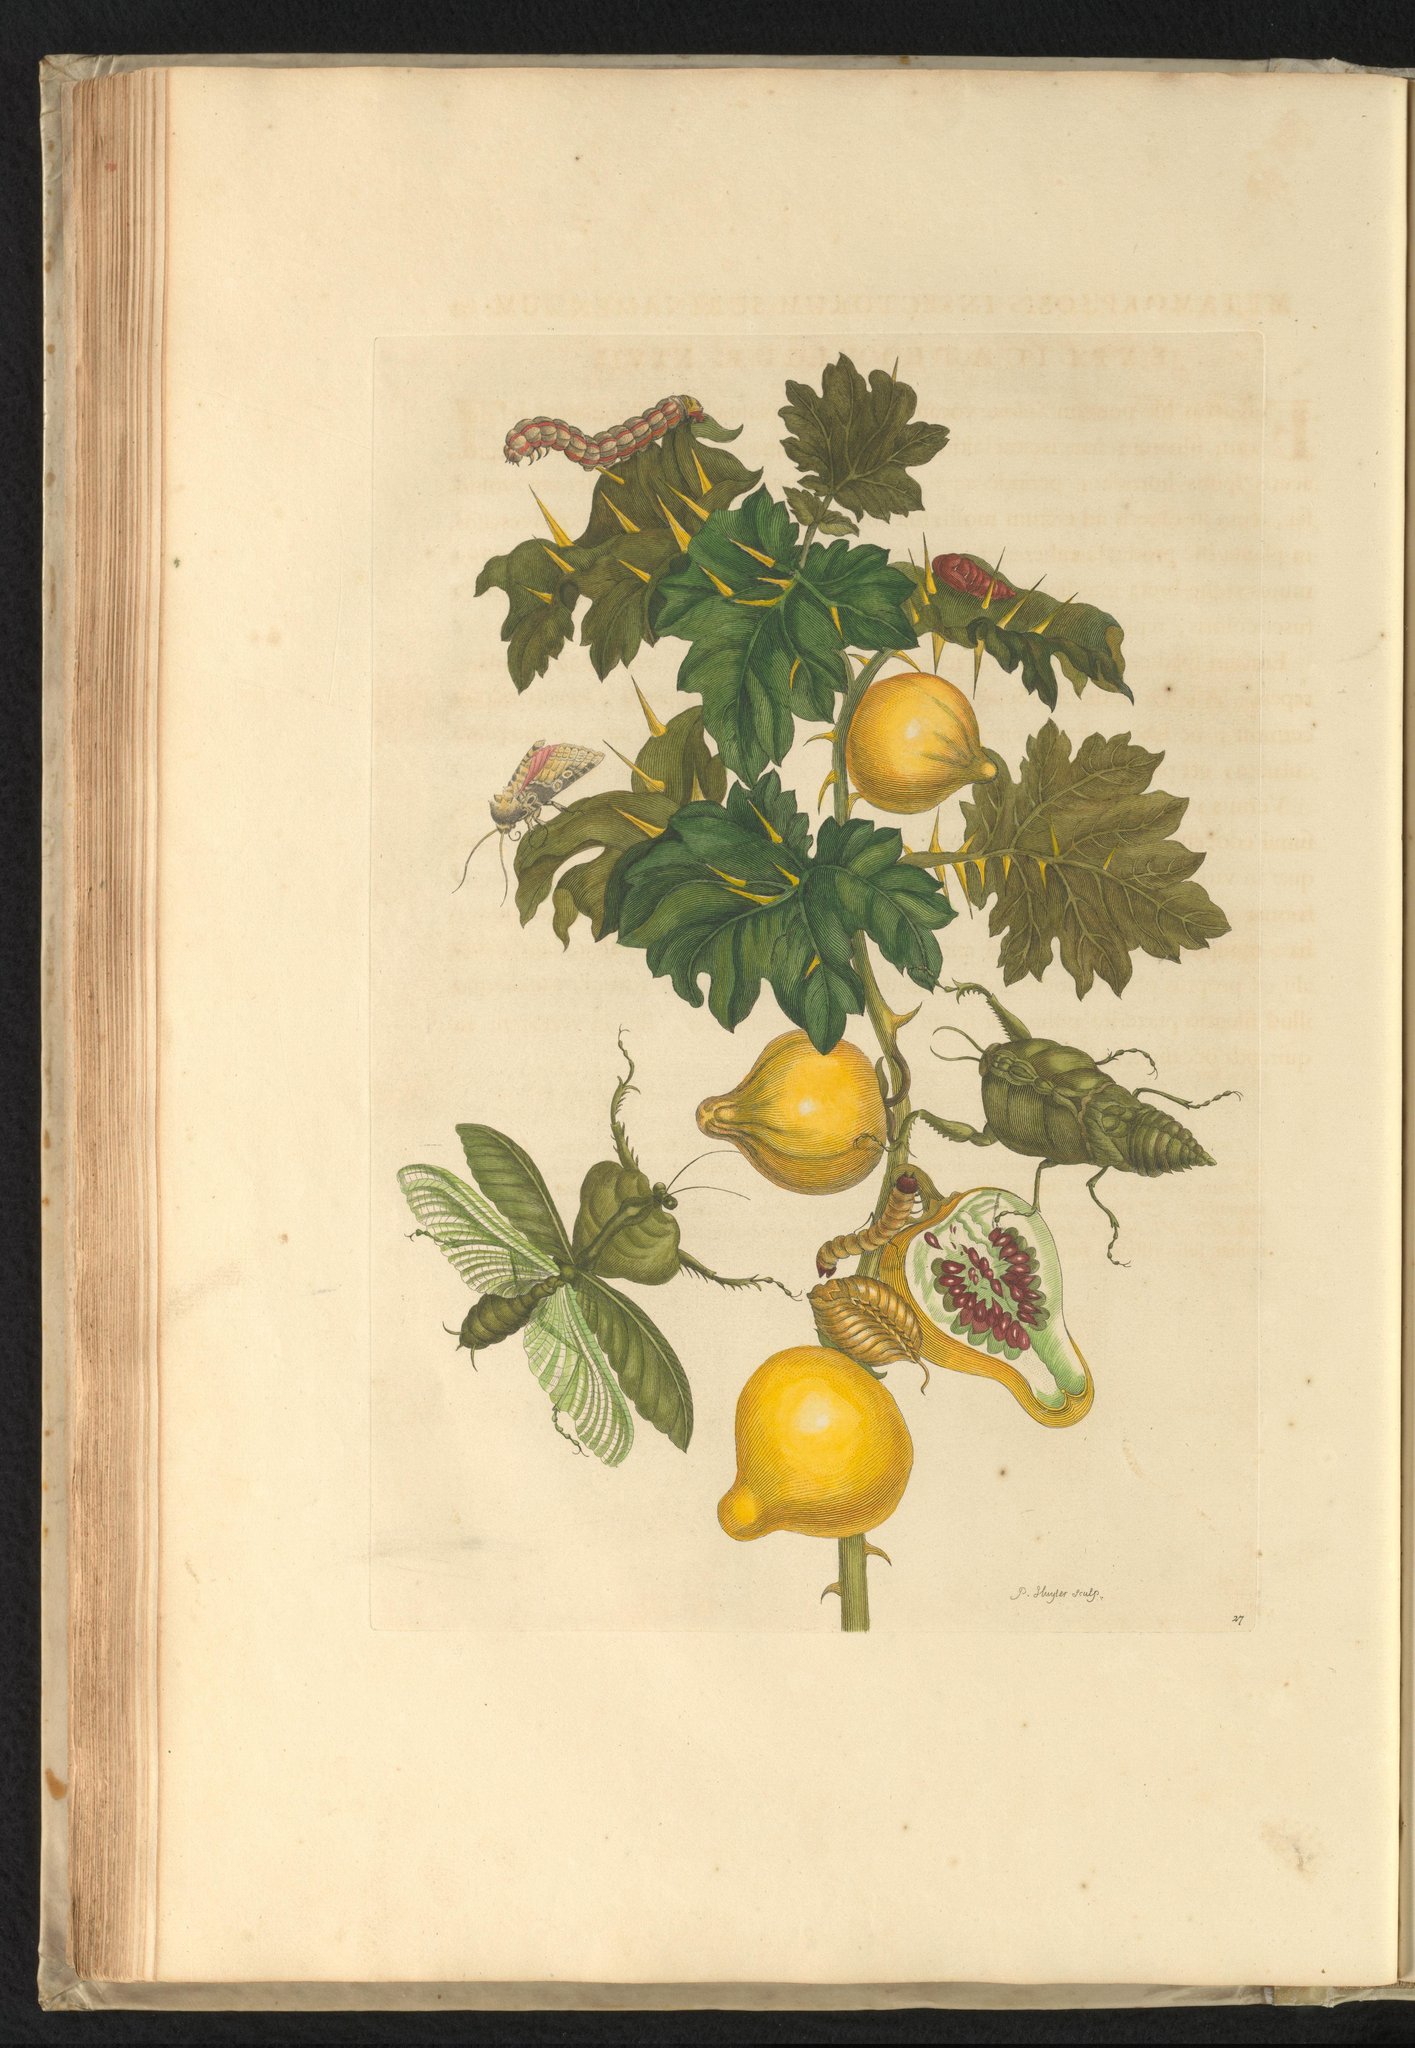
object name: page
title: Nippel fruit (Solanum mammosum) met twee bidsprinkhanen, rupsen en andere insecten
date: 1705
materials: paper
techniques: etching, hand coloring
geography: amsterdam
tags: insects: pupa, insects: moth, insects: caterpillar, insects: praying-mantis, fruits, suriname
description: Rechtsonder genummerd: 27. Prent maakt deel uit van een boek.